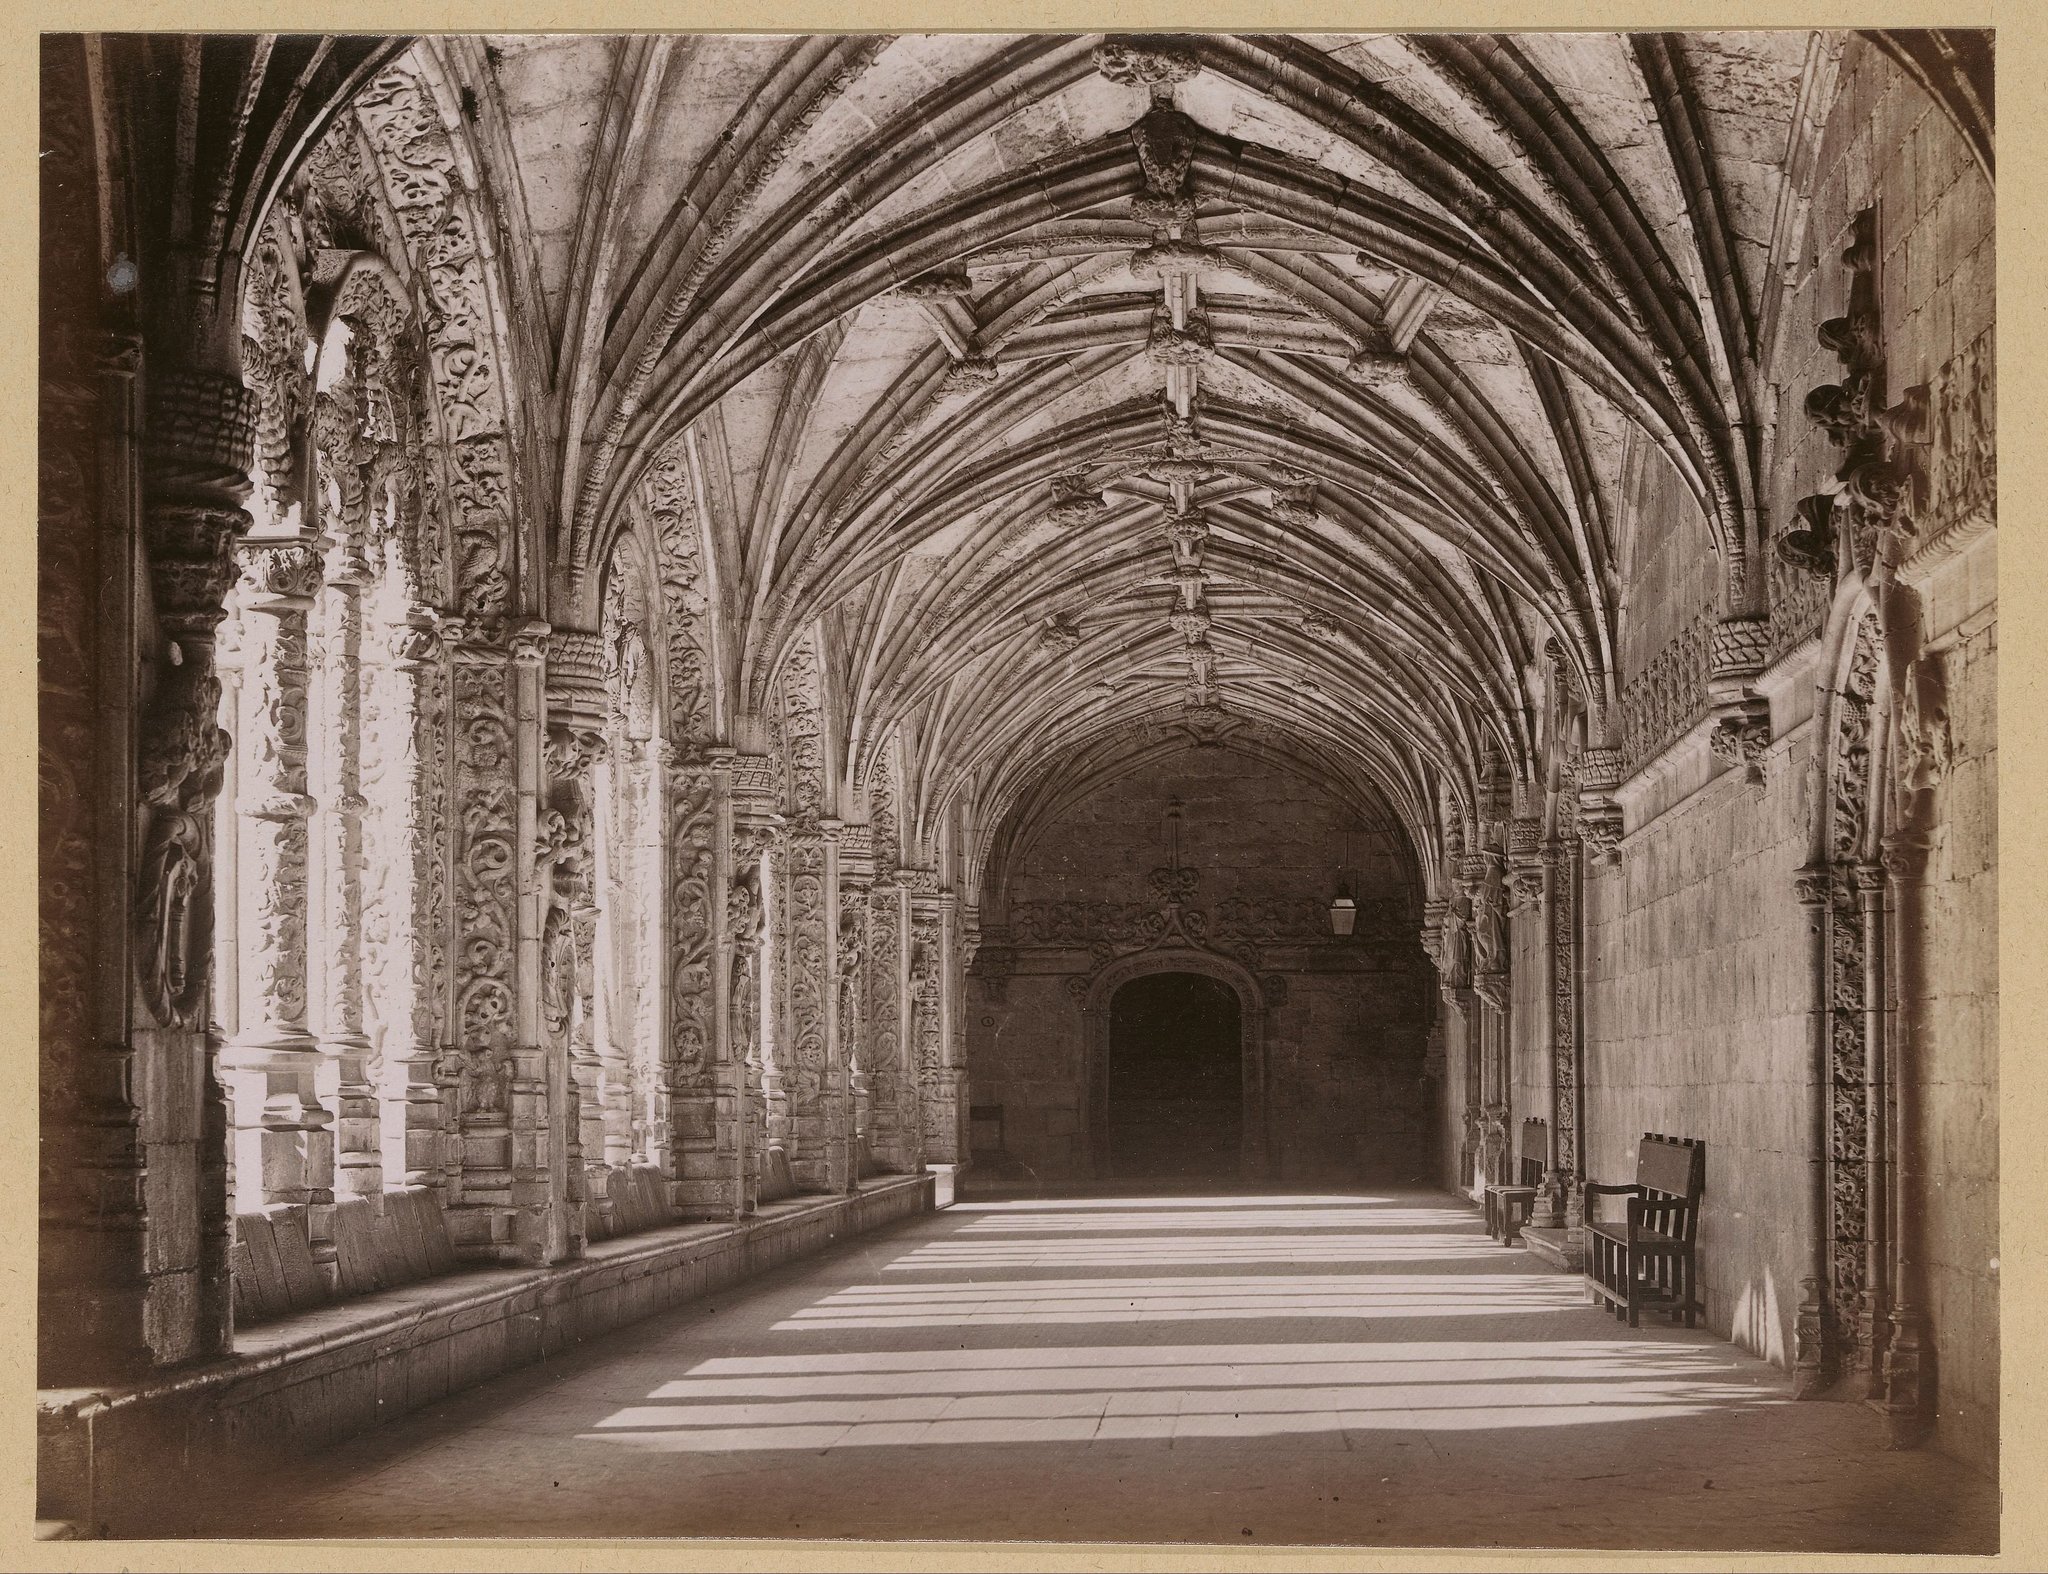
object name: photograph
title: Kloostergang in het Mosteiro dos Jerónimos in Lissabon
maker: Anonymous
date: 1851-1890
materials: paper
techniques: albumen print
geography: lisbon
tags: parts of church interior: ambulatory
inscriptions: inscription: ‘Belem/ Lissabon’